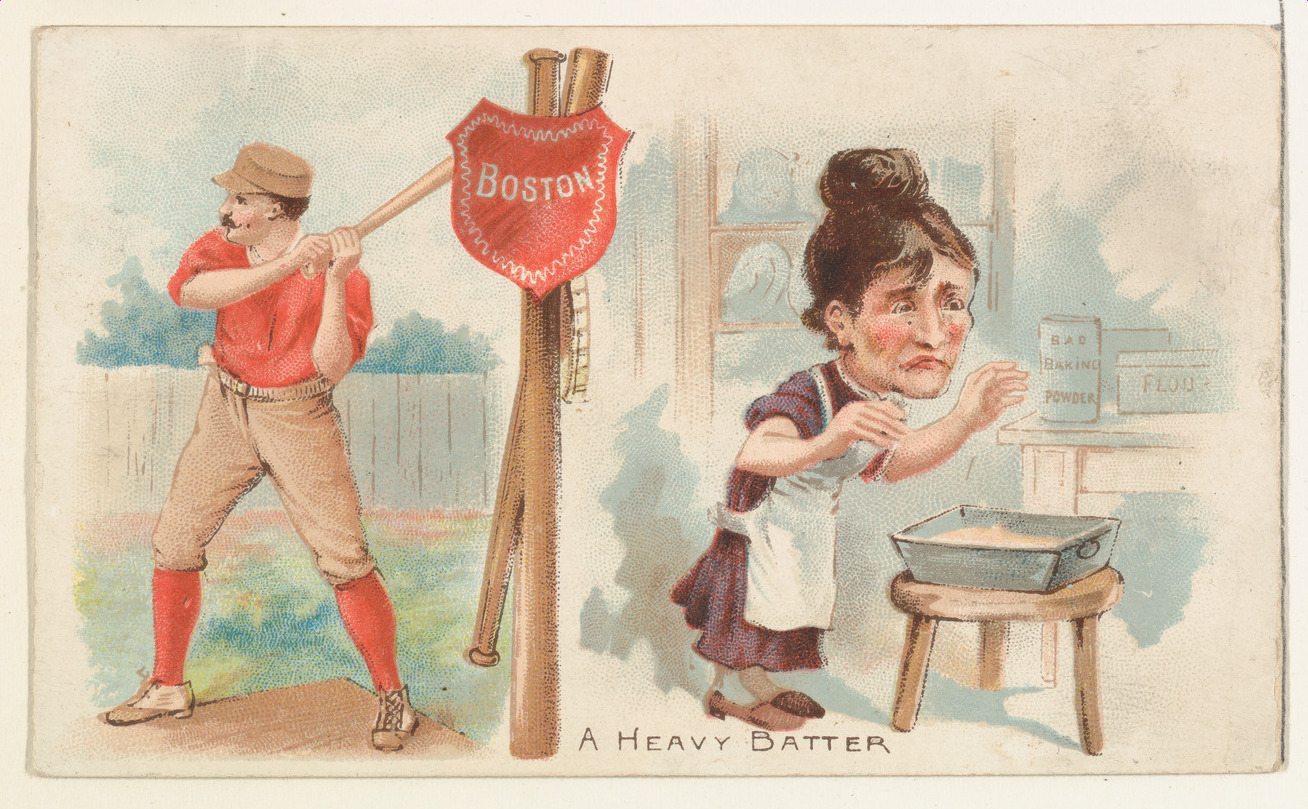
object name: print, baseball card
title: A Heavy Batter, from the Talk of the Diamond set (N135) issued by Duke Sons & Co., a branch of the American Tobacco Company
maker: w. duke, sons & co.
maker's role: publisher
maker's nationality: american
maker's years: 1870-1920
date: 1888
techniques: color lithograph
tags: men,women,baseball,athletes